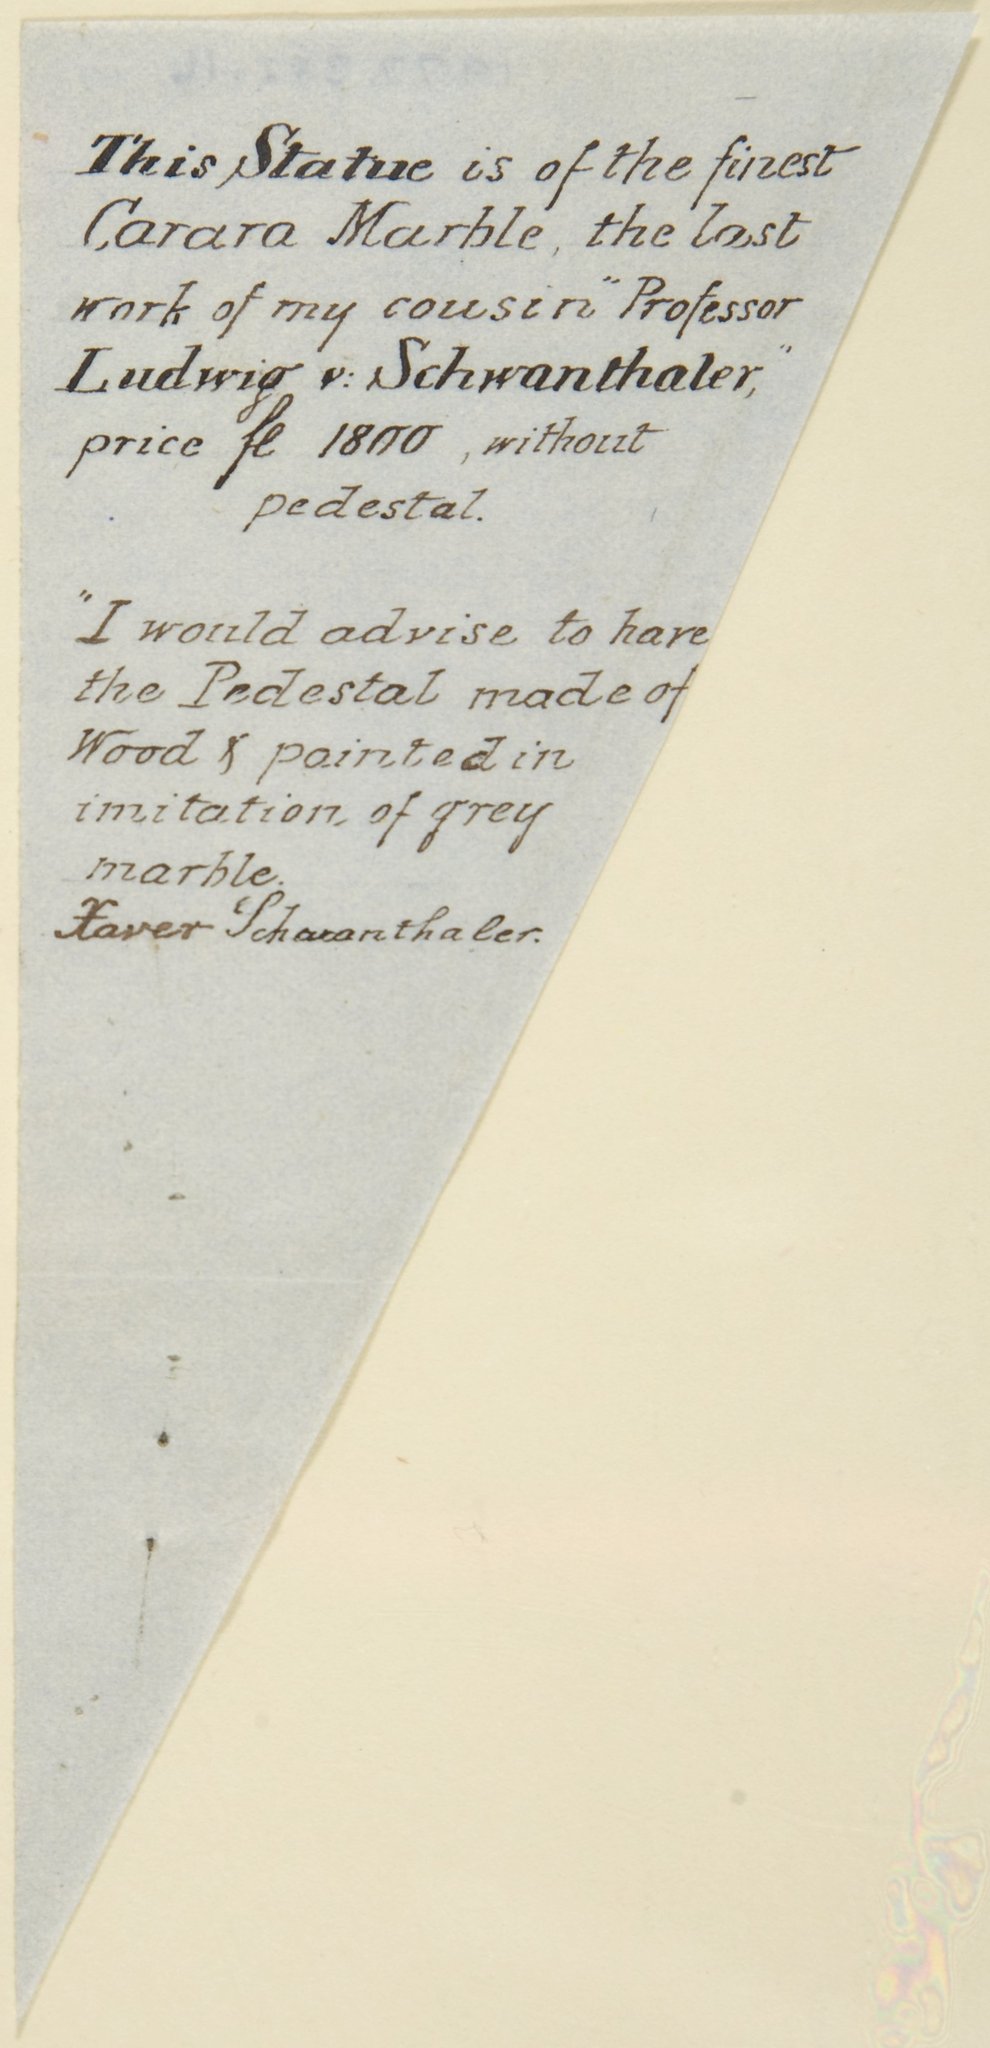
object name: letter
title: Explanatory note relating to sculpture of Nymphy by Ludwig Michael von Schwanthaler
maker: franz xaver schwanthaler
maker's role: author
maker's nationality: german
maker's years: 1799-1854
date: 1850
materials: ink, paper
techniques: pen